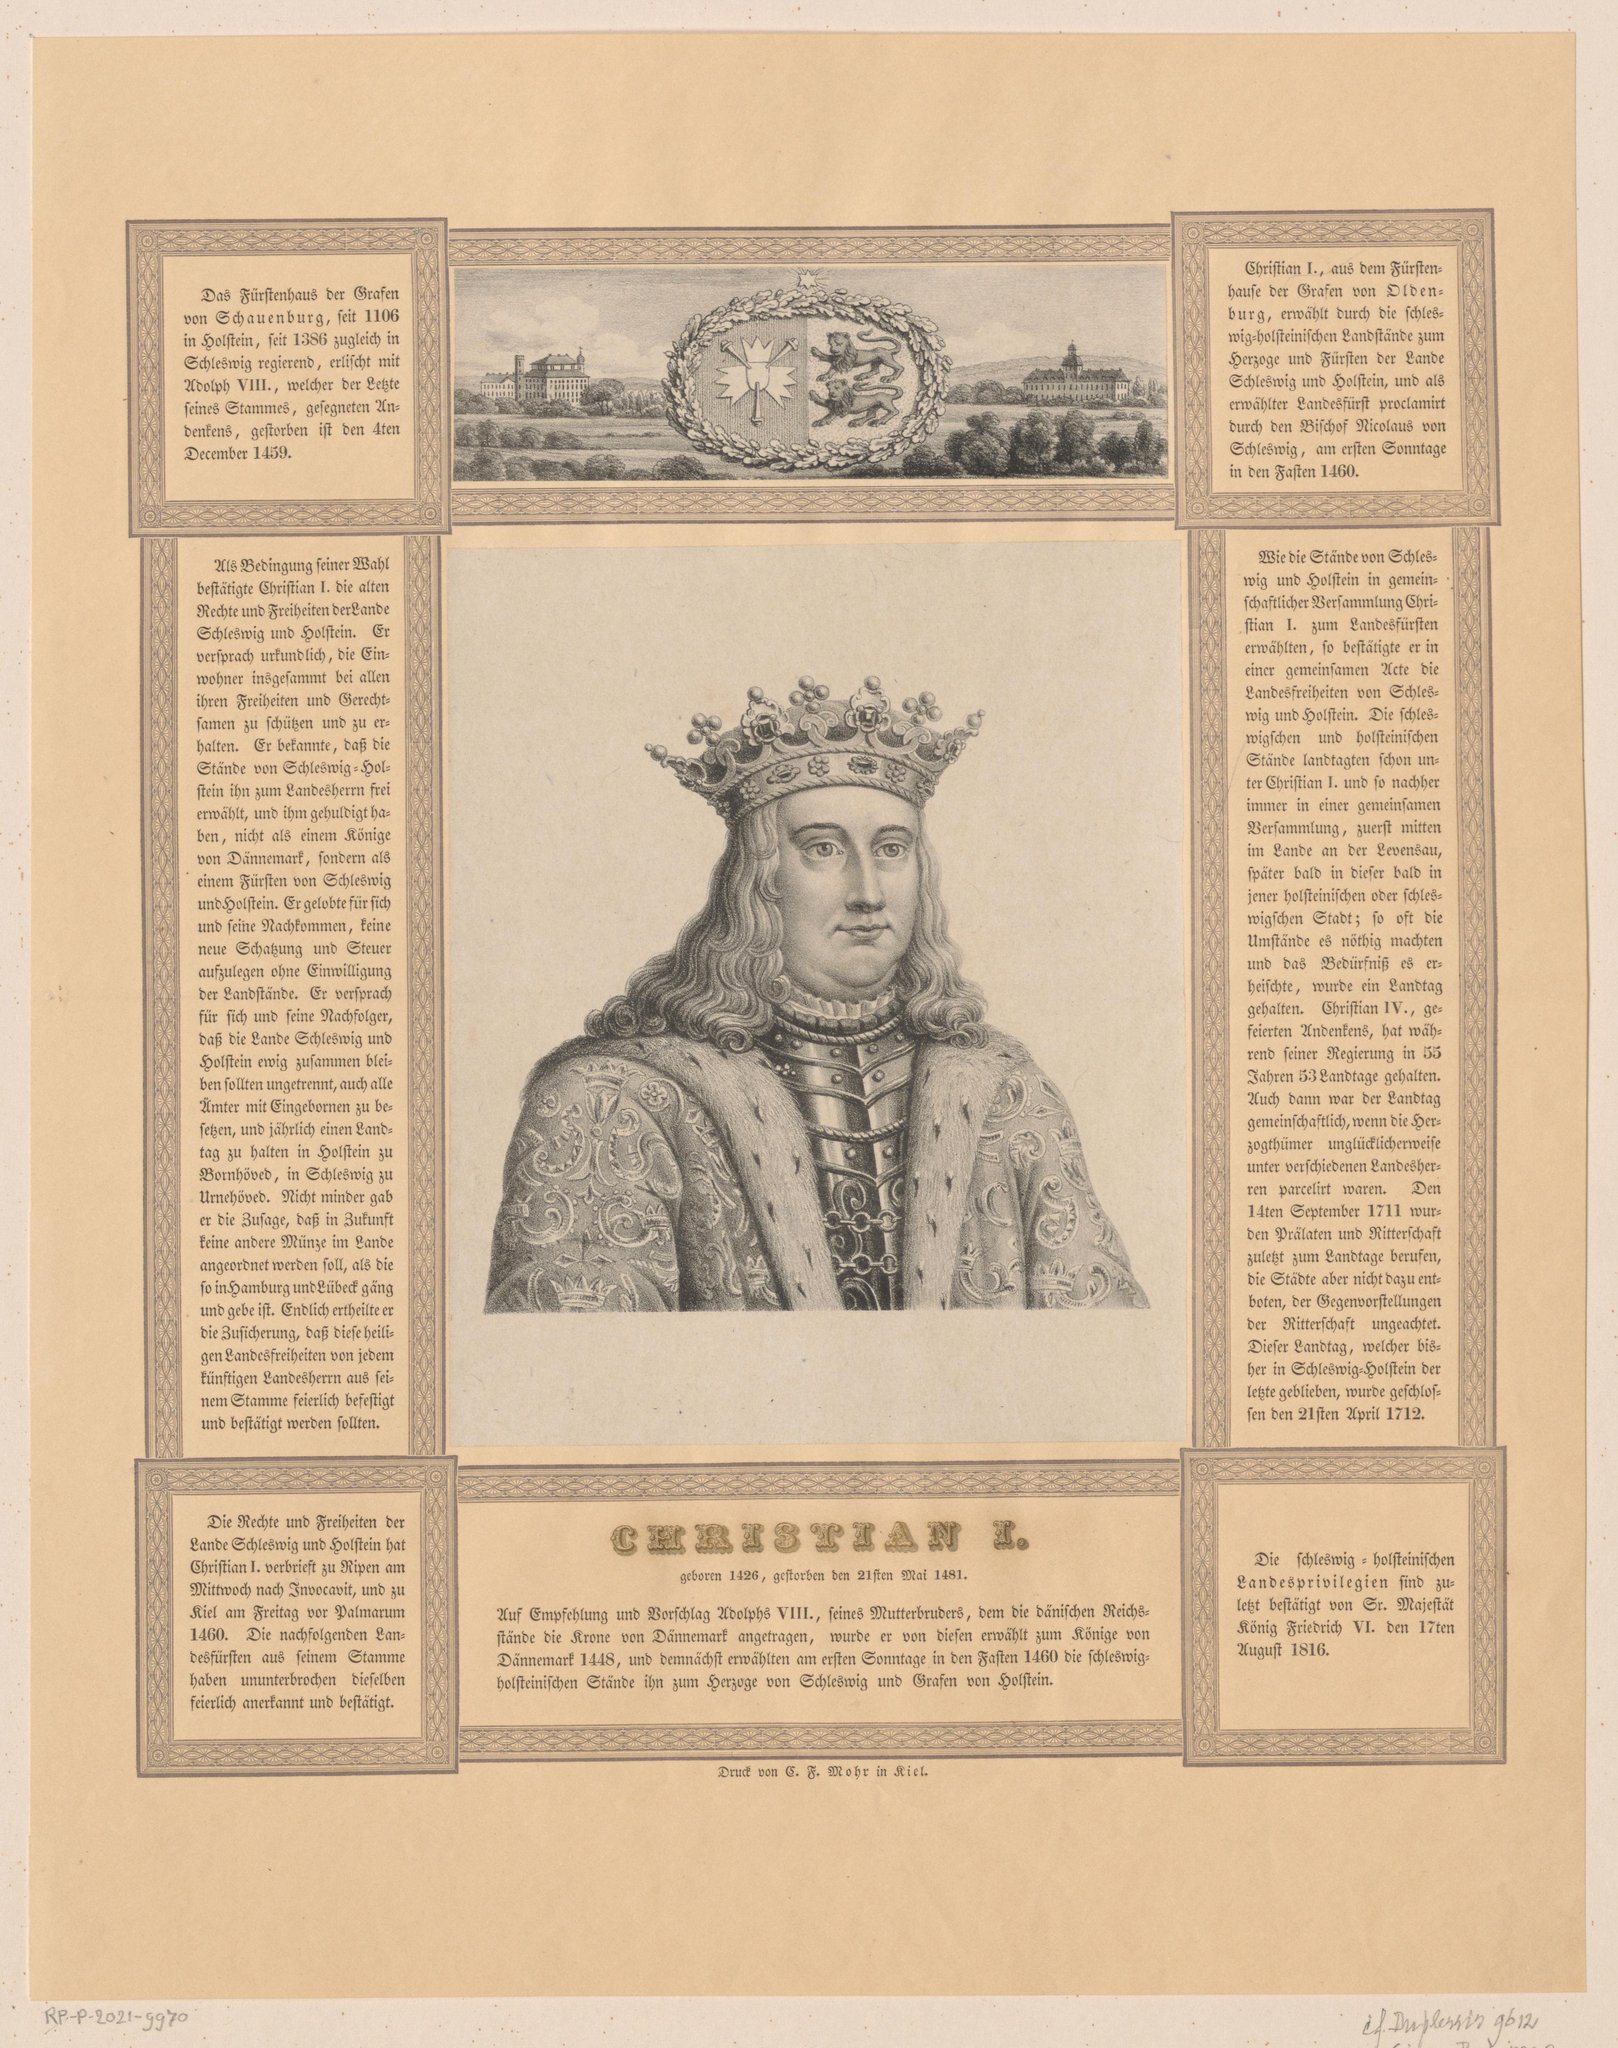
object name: print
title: Portret van Christiaan I, koning van Denemarken, Noorwegen en Zweden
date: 1800-1899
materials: paper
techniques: letterpress printing, lithograph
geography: kiel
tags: copenhagen (city), historical persons, king, armorial bearing, heraldry